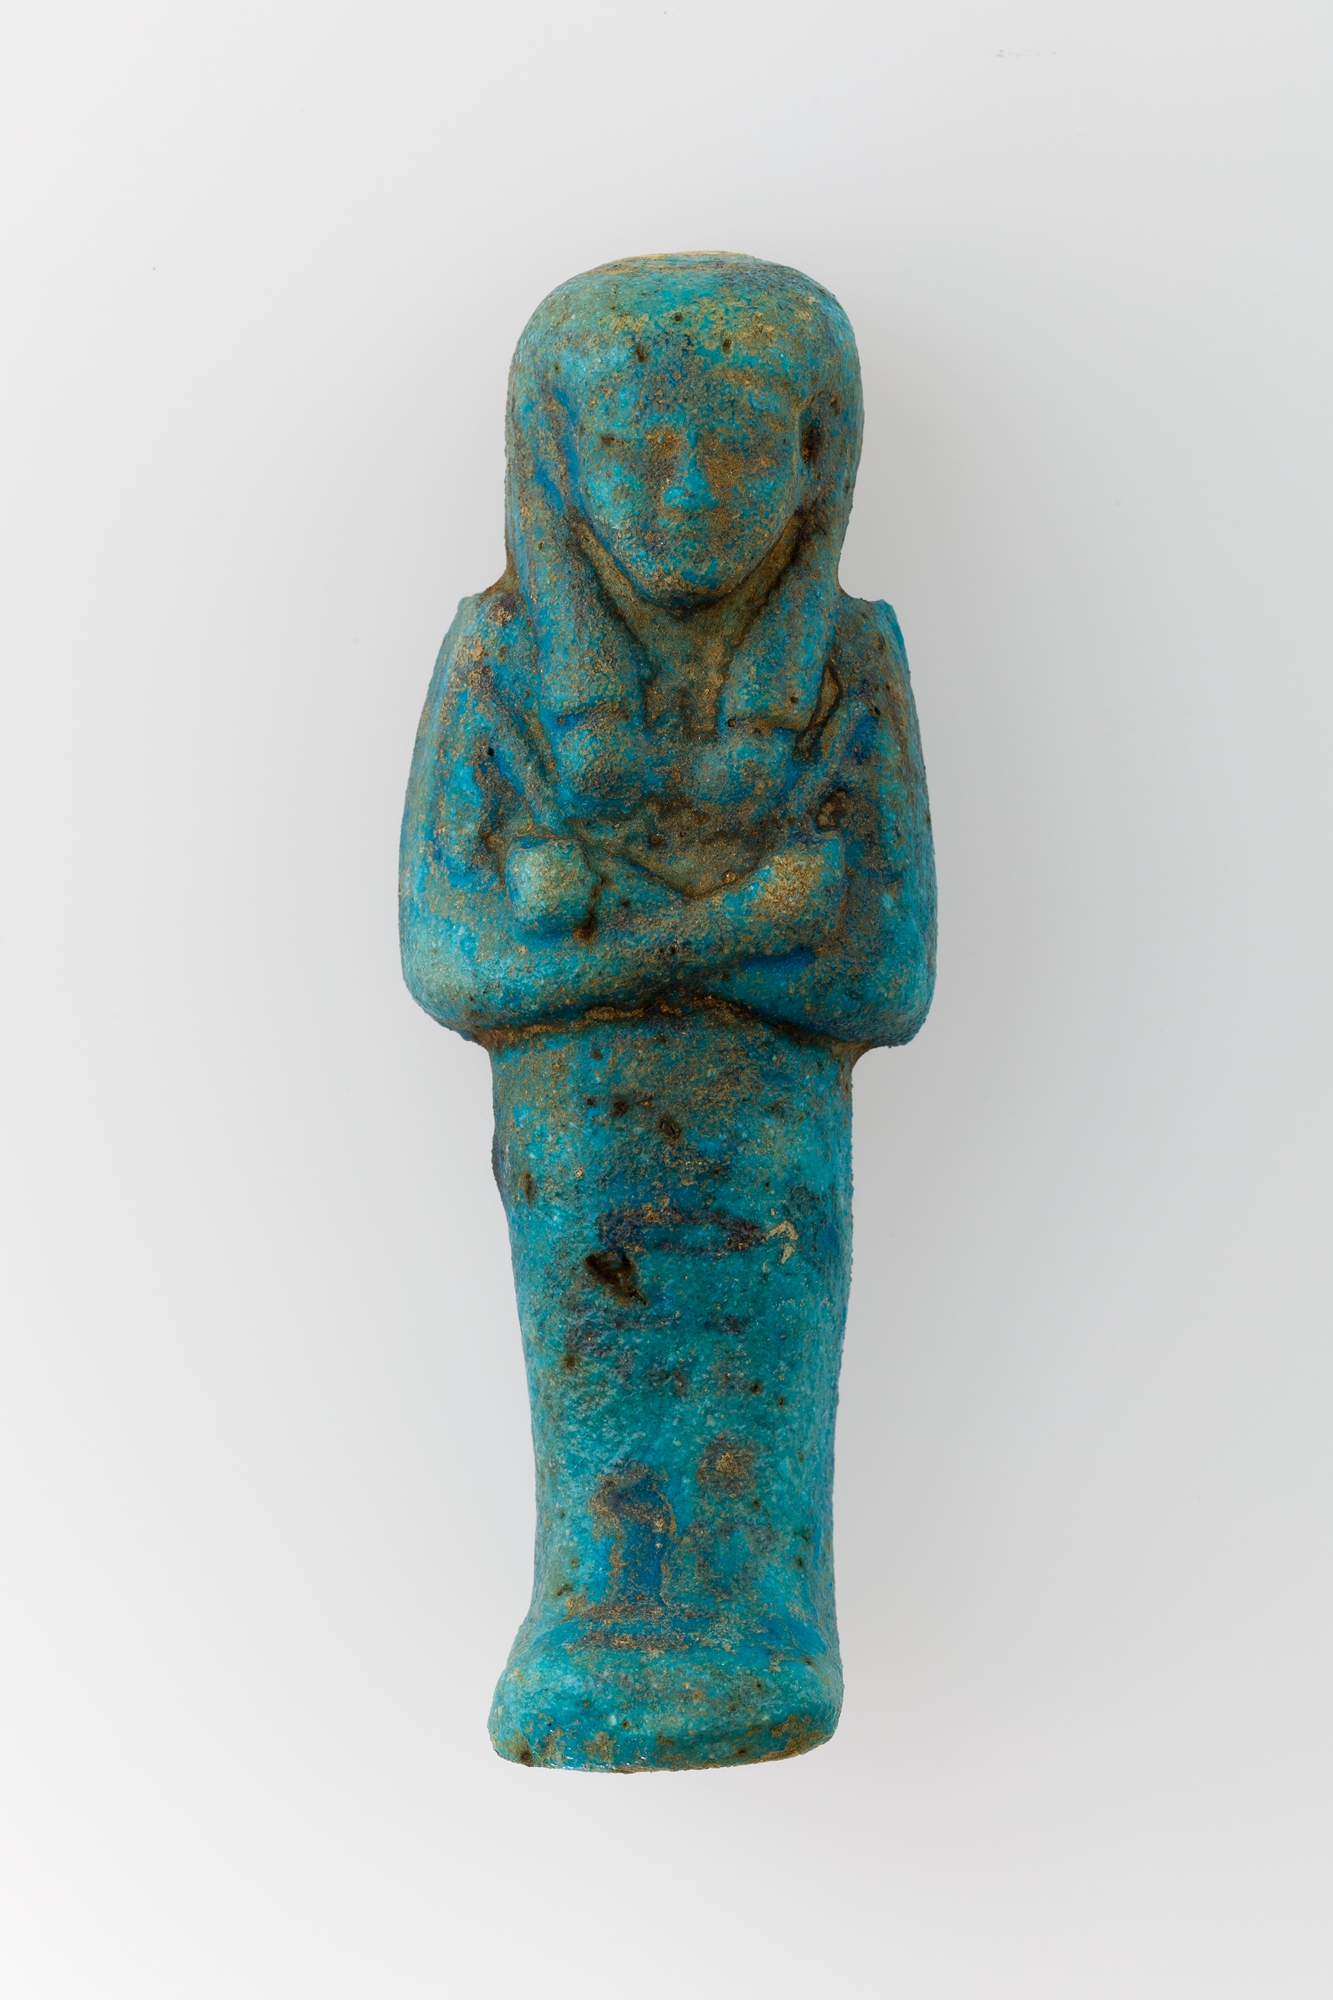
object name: shabti, henettawy c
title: Worker Shabti of Henettawy (C), Daughter of Isetemkheb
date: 990-970 BCE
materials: faience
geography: egypt